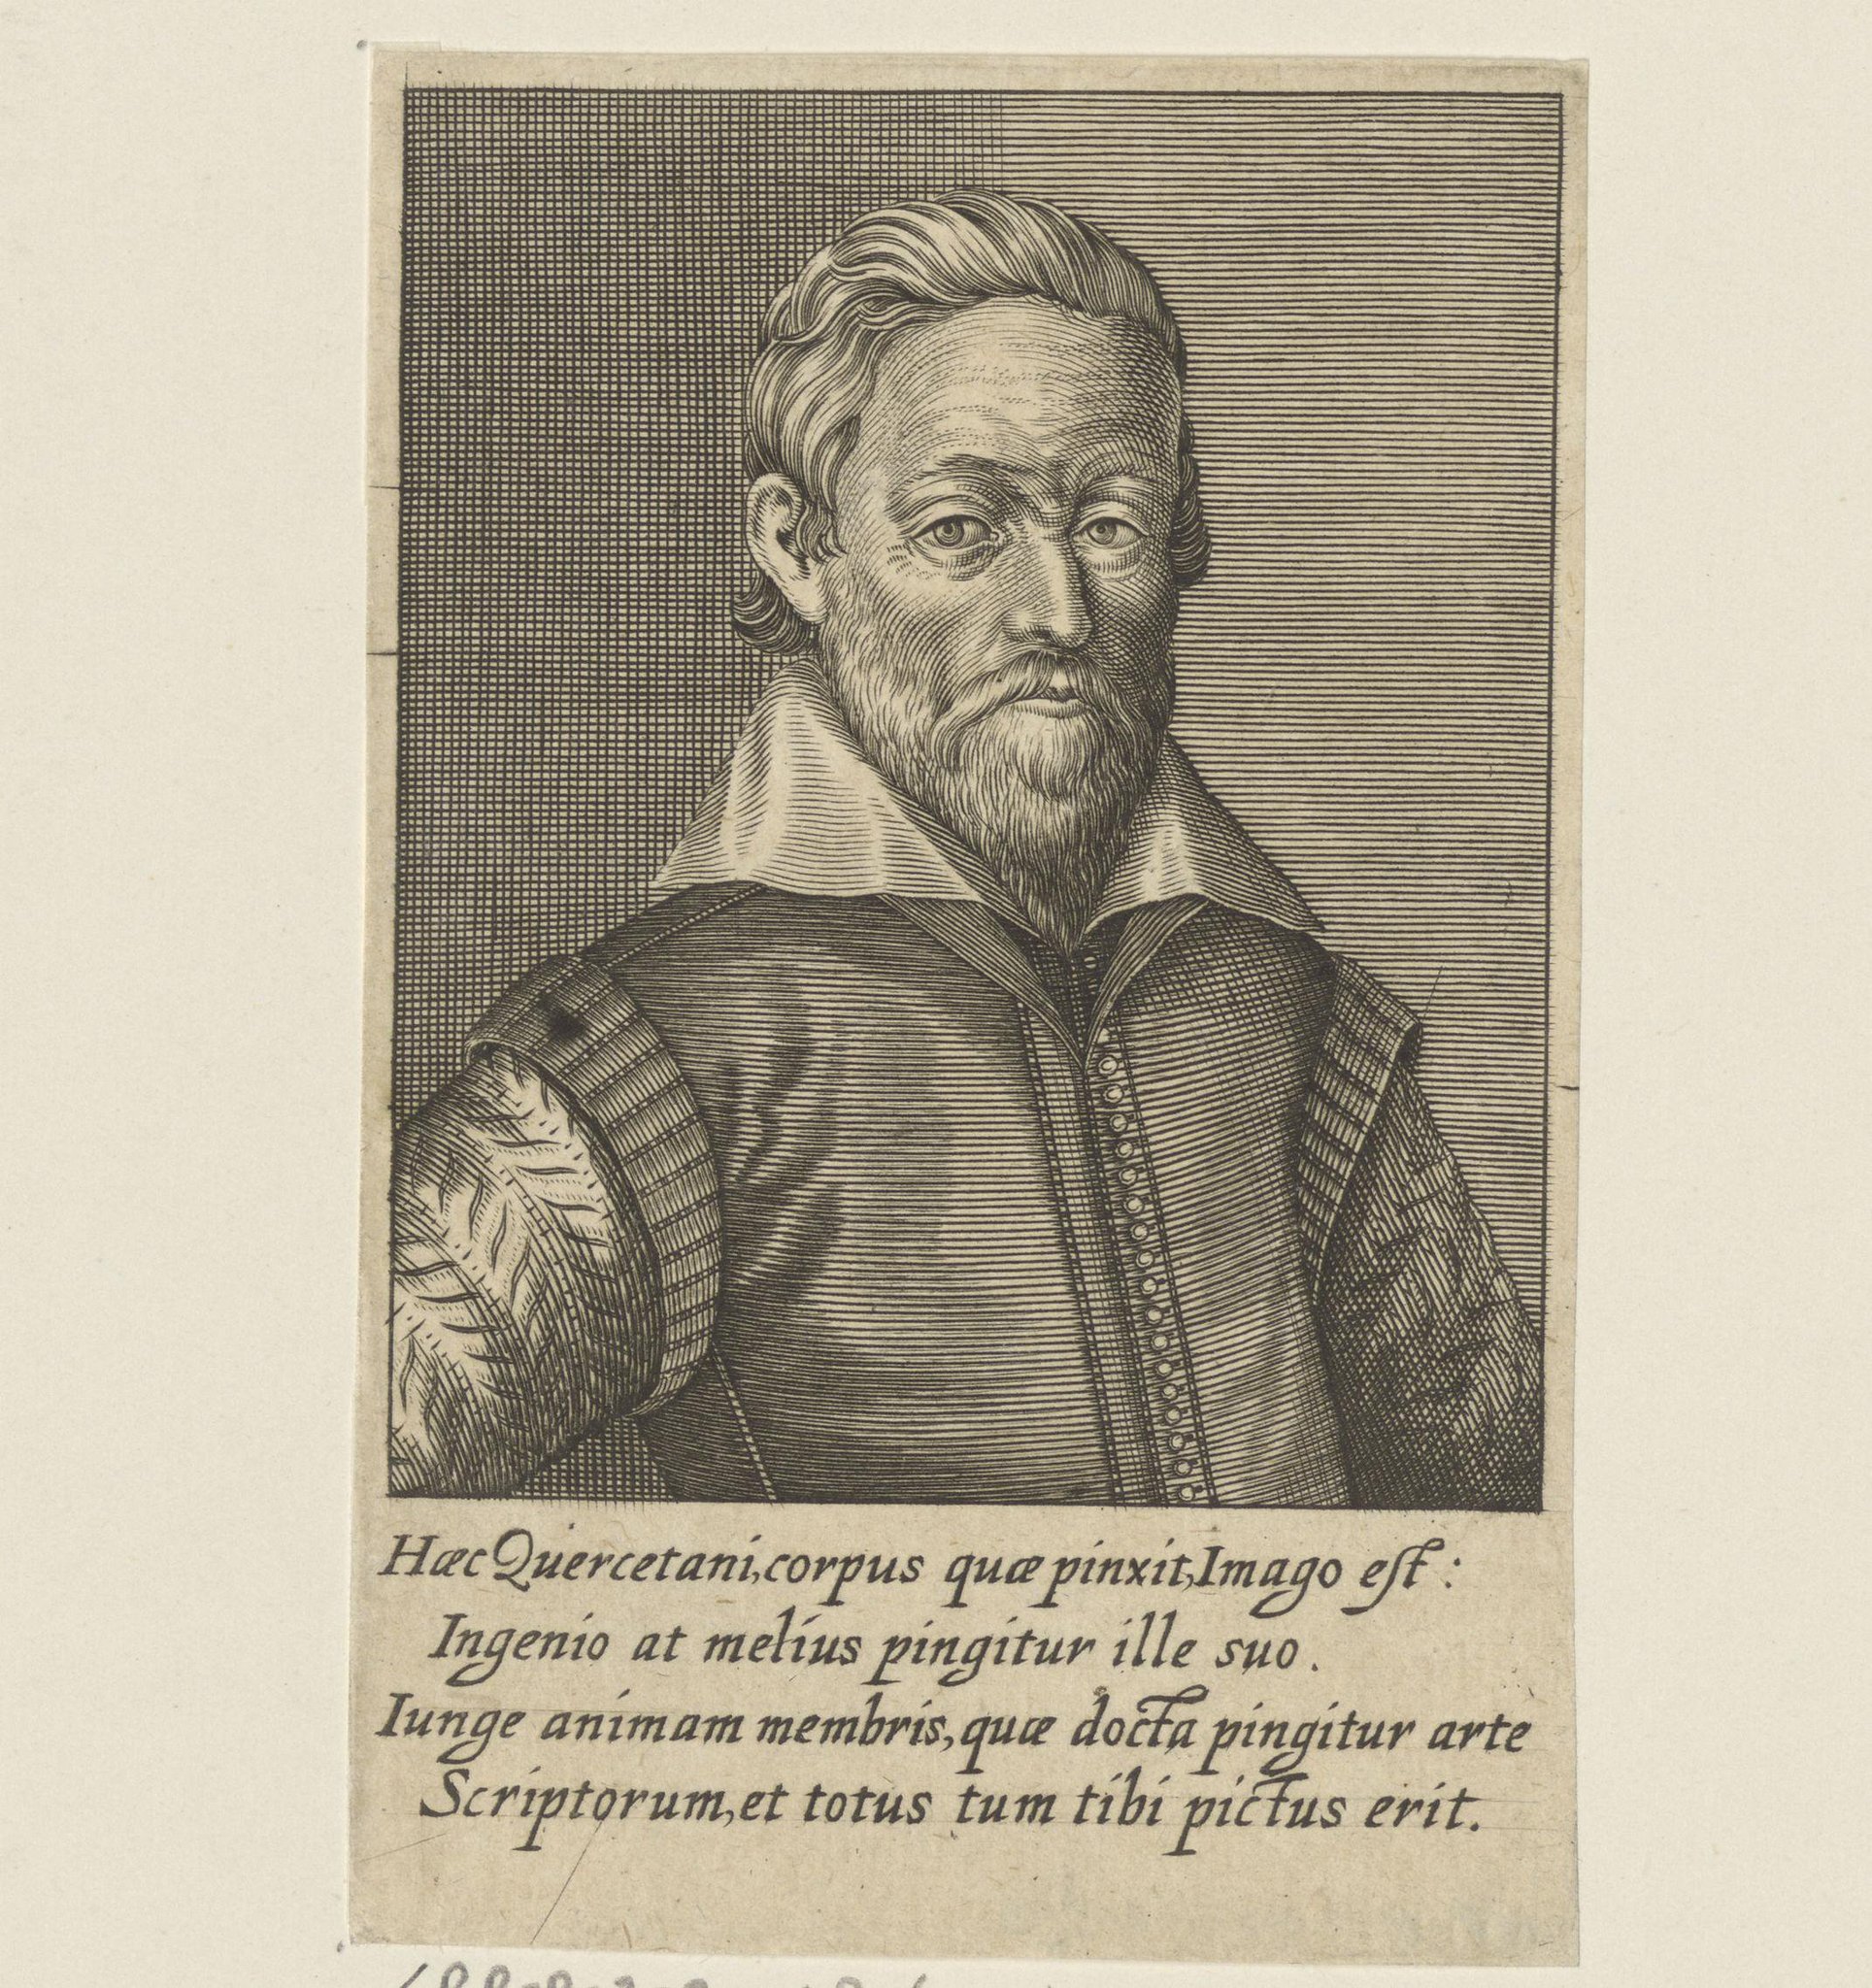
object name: print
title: Portret van Joseph Duchesne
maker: Anonymous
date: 1600-1699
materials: paper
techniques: engraving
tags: historical persons